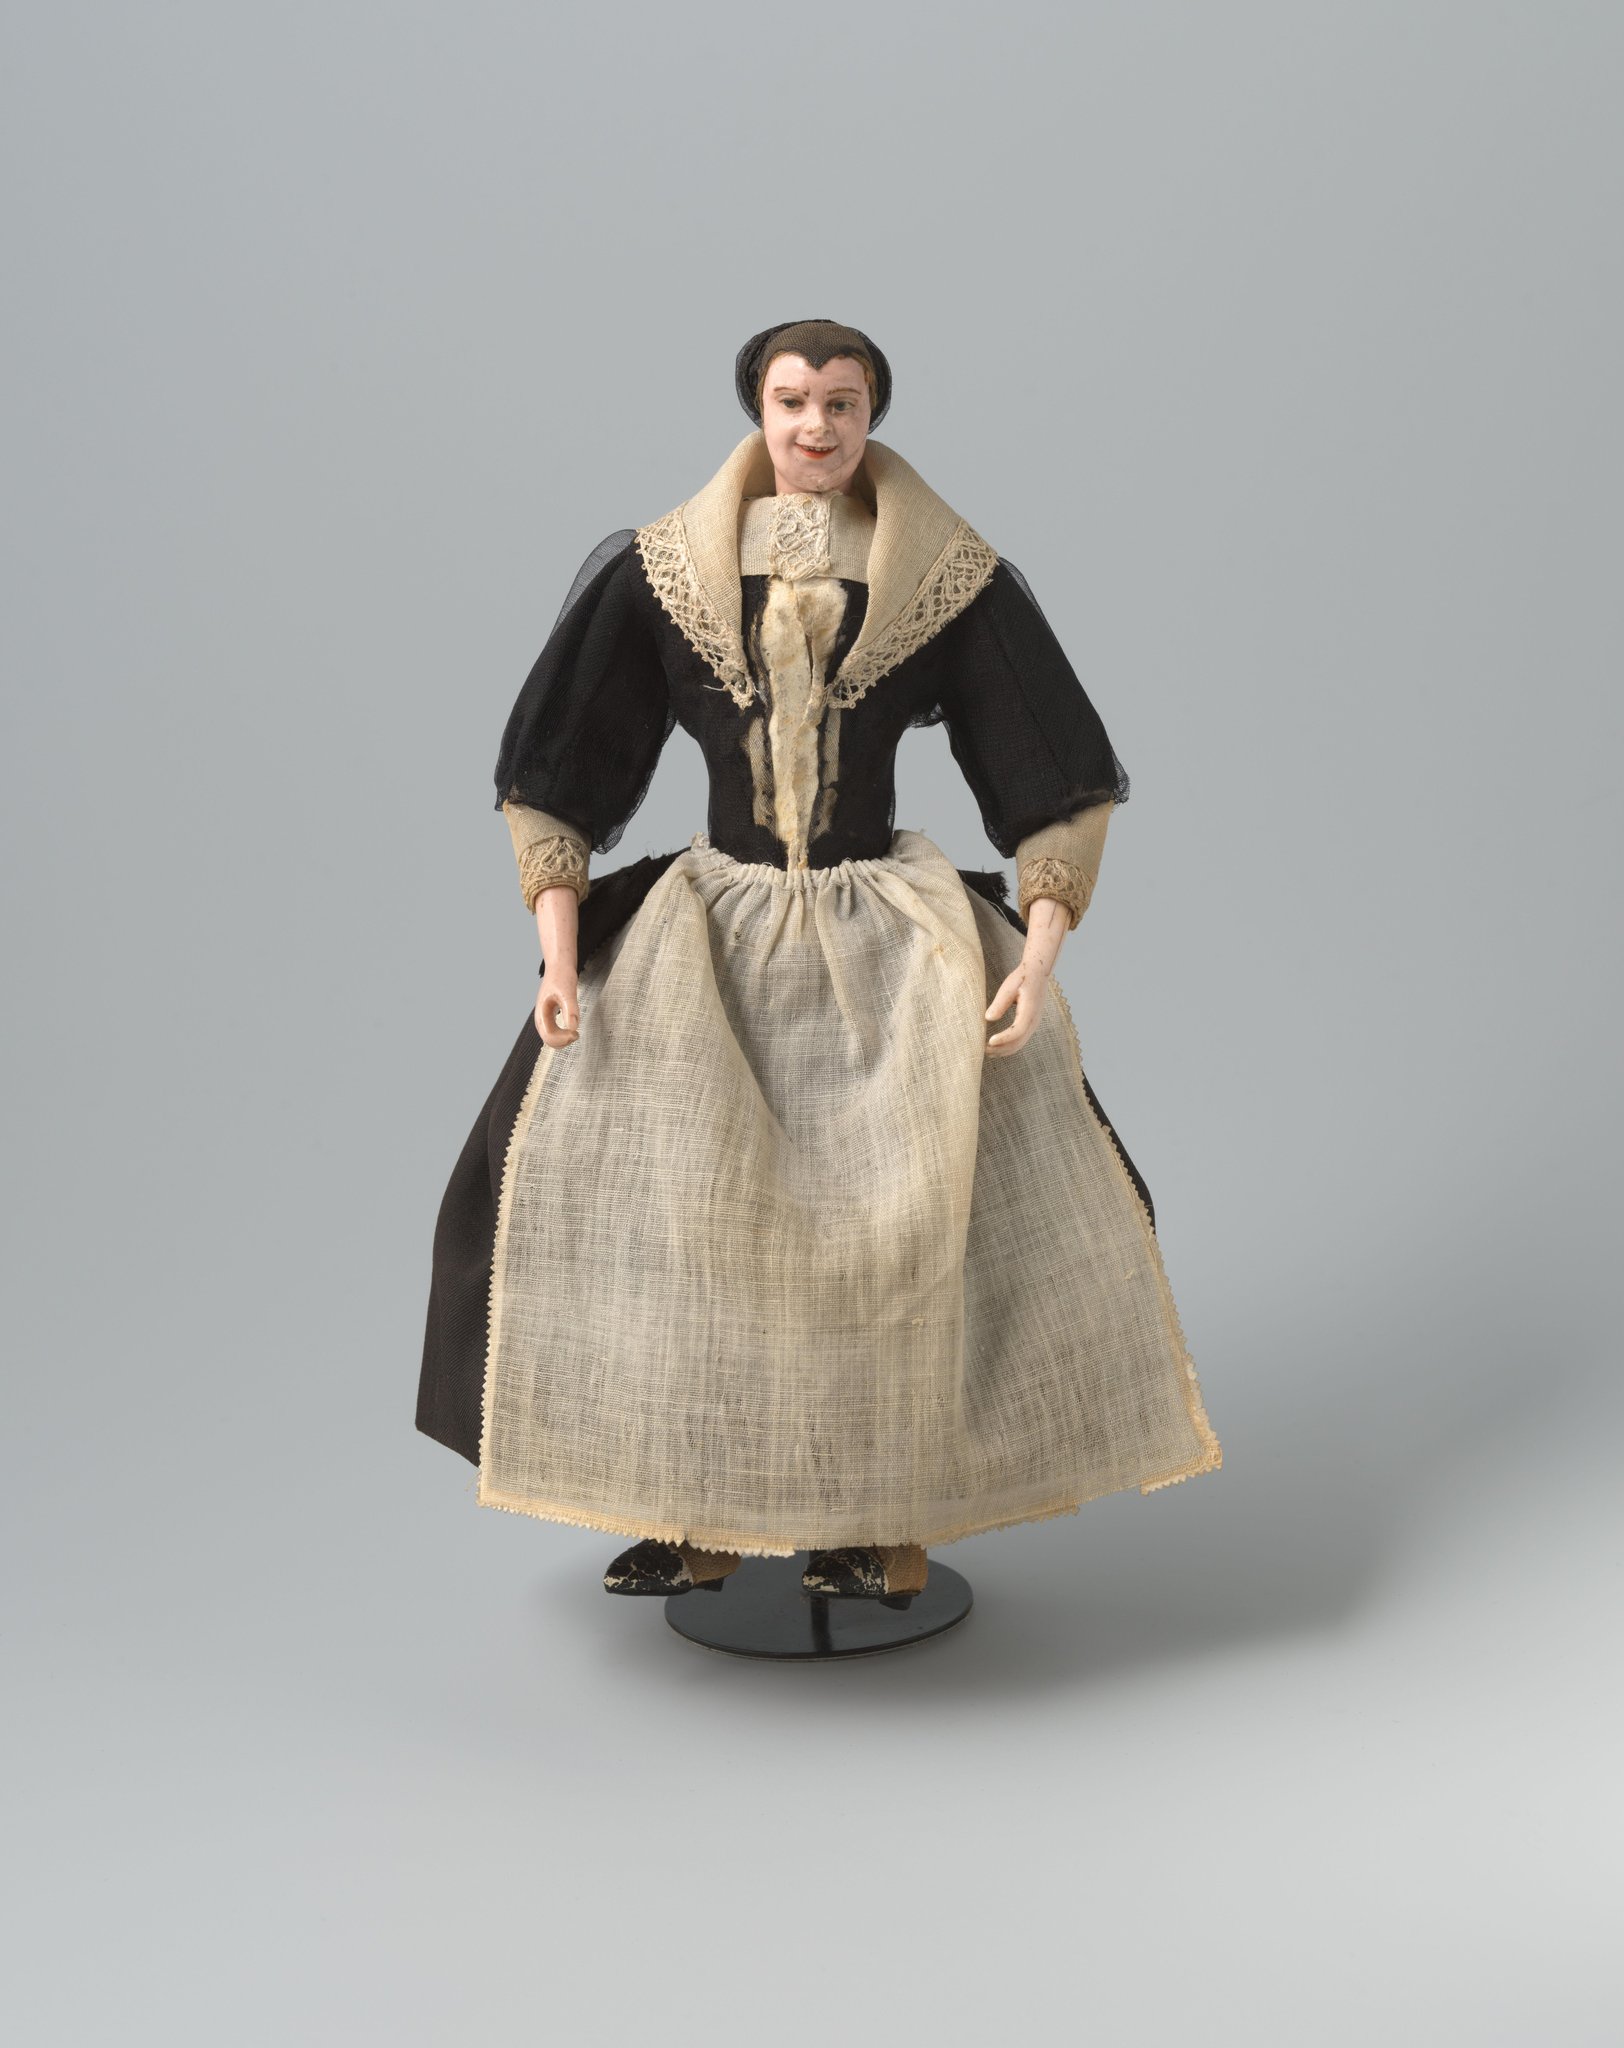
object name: miniature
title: Pop, voorstellende de vroedvrouw of baker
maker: Anonymous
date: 1676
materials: hair, linen, metal, paper, silk, fiber, velvet, wax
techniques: lace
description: Pop, voorstellende de vroedvrouw of baker, gekleed in een zwart hooggesloten jak, een enkellange rok van zwart gekeperde wollen stof, en een wit schort van linnen batist.